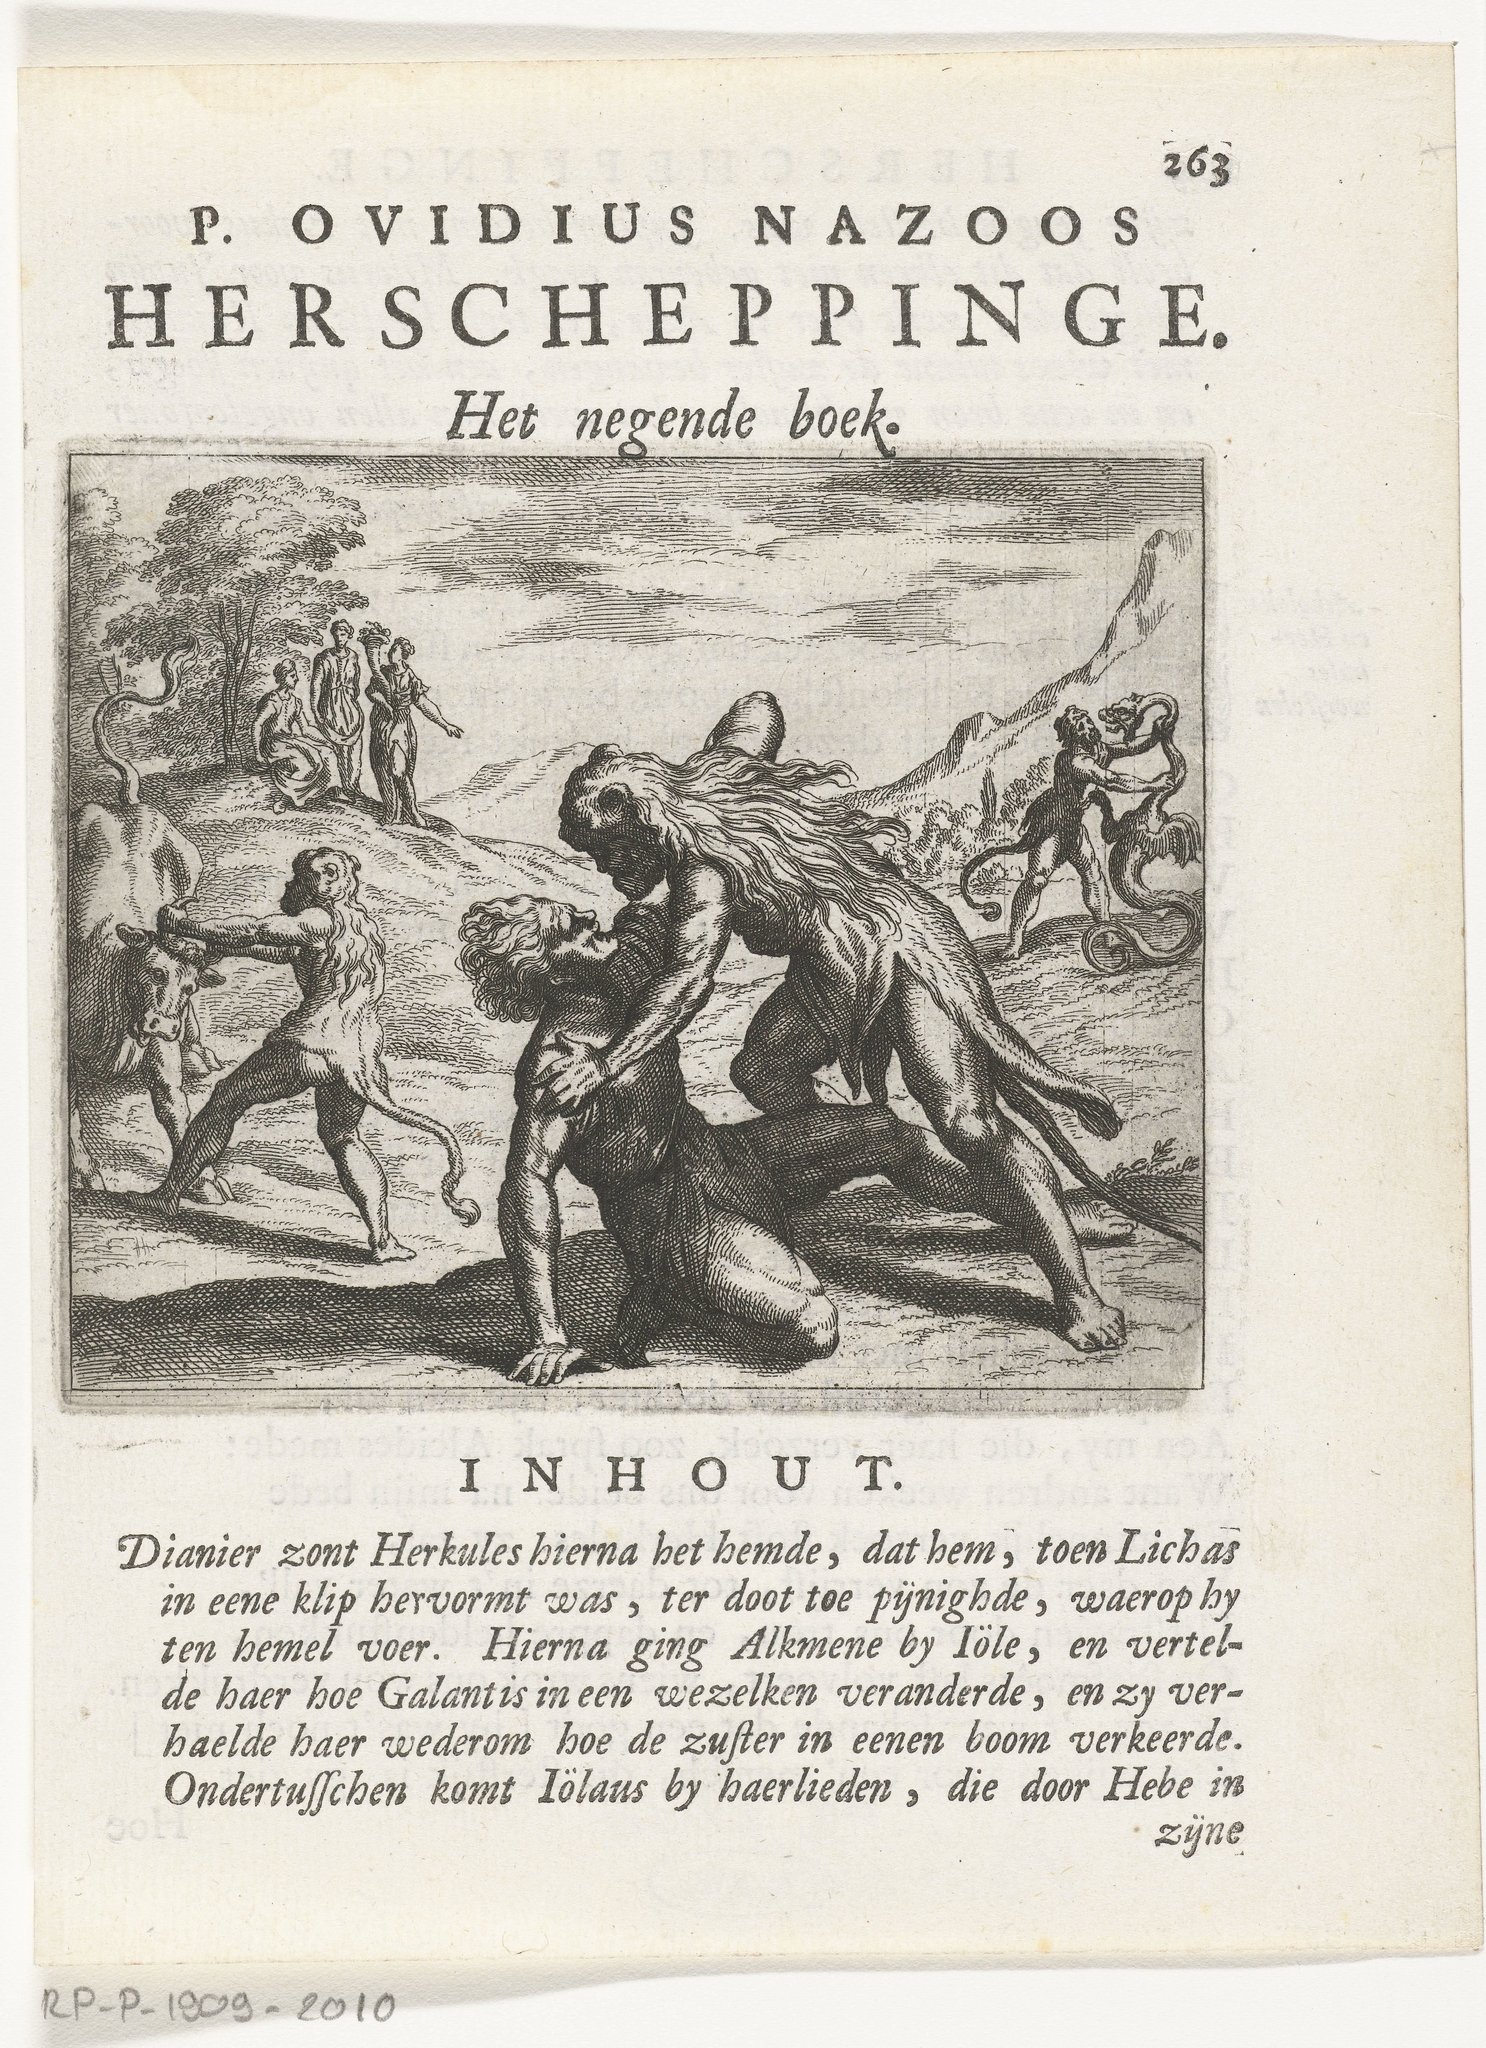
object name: book illustration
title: Herscheppinge van Publius Ovidius Naso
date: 1671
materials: paper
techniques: etching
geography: amsterdam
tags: while fighting with hercules the river-god achelous changes himself into a serpent, while fighting with hercules the river-god achelous changes himself into a bull, or a bull-headed man, hercules breaks off a horn; naiads fill the horn with flowers and fruits; it thus becomes the cornucopia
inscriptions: collector's mark: Lugt 2228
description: Bladzijde uit een boek met tekst op recto en verso en een afbeelding aan het begin van boek 9. Hercules met de leeuwenhuid aan worstelt met de riviergod Acheloüs. Die neemt tijdens de strijd verschillende gedaantes aan. Links worstelt Hercules met een stier, rechts met een slang. Hercules breekt een hoorn van de stier af. Op de achtergrond maakt een groepje nimfen een hoorn des overvloeds van de afgebroken hoorn.